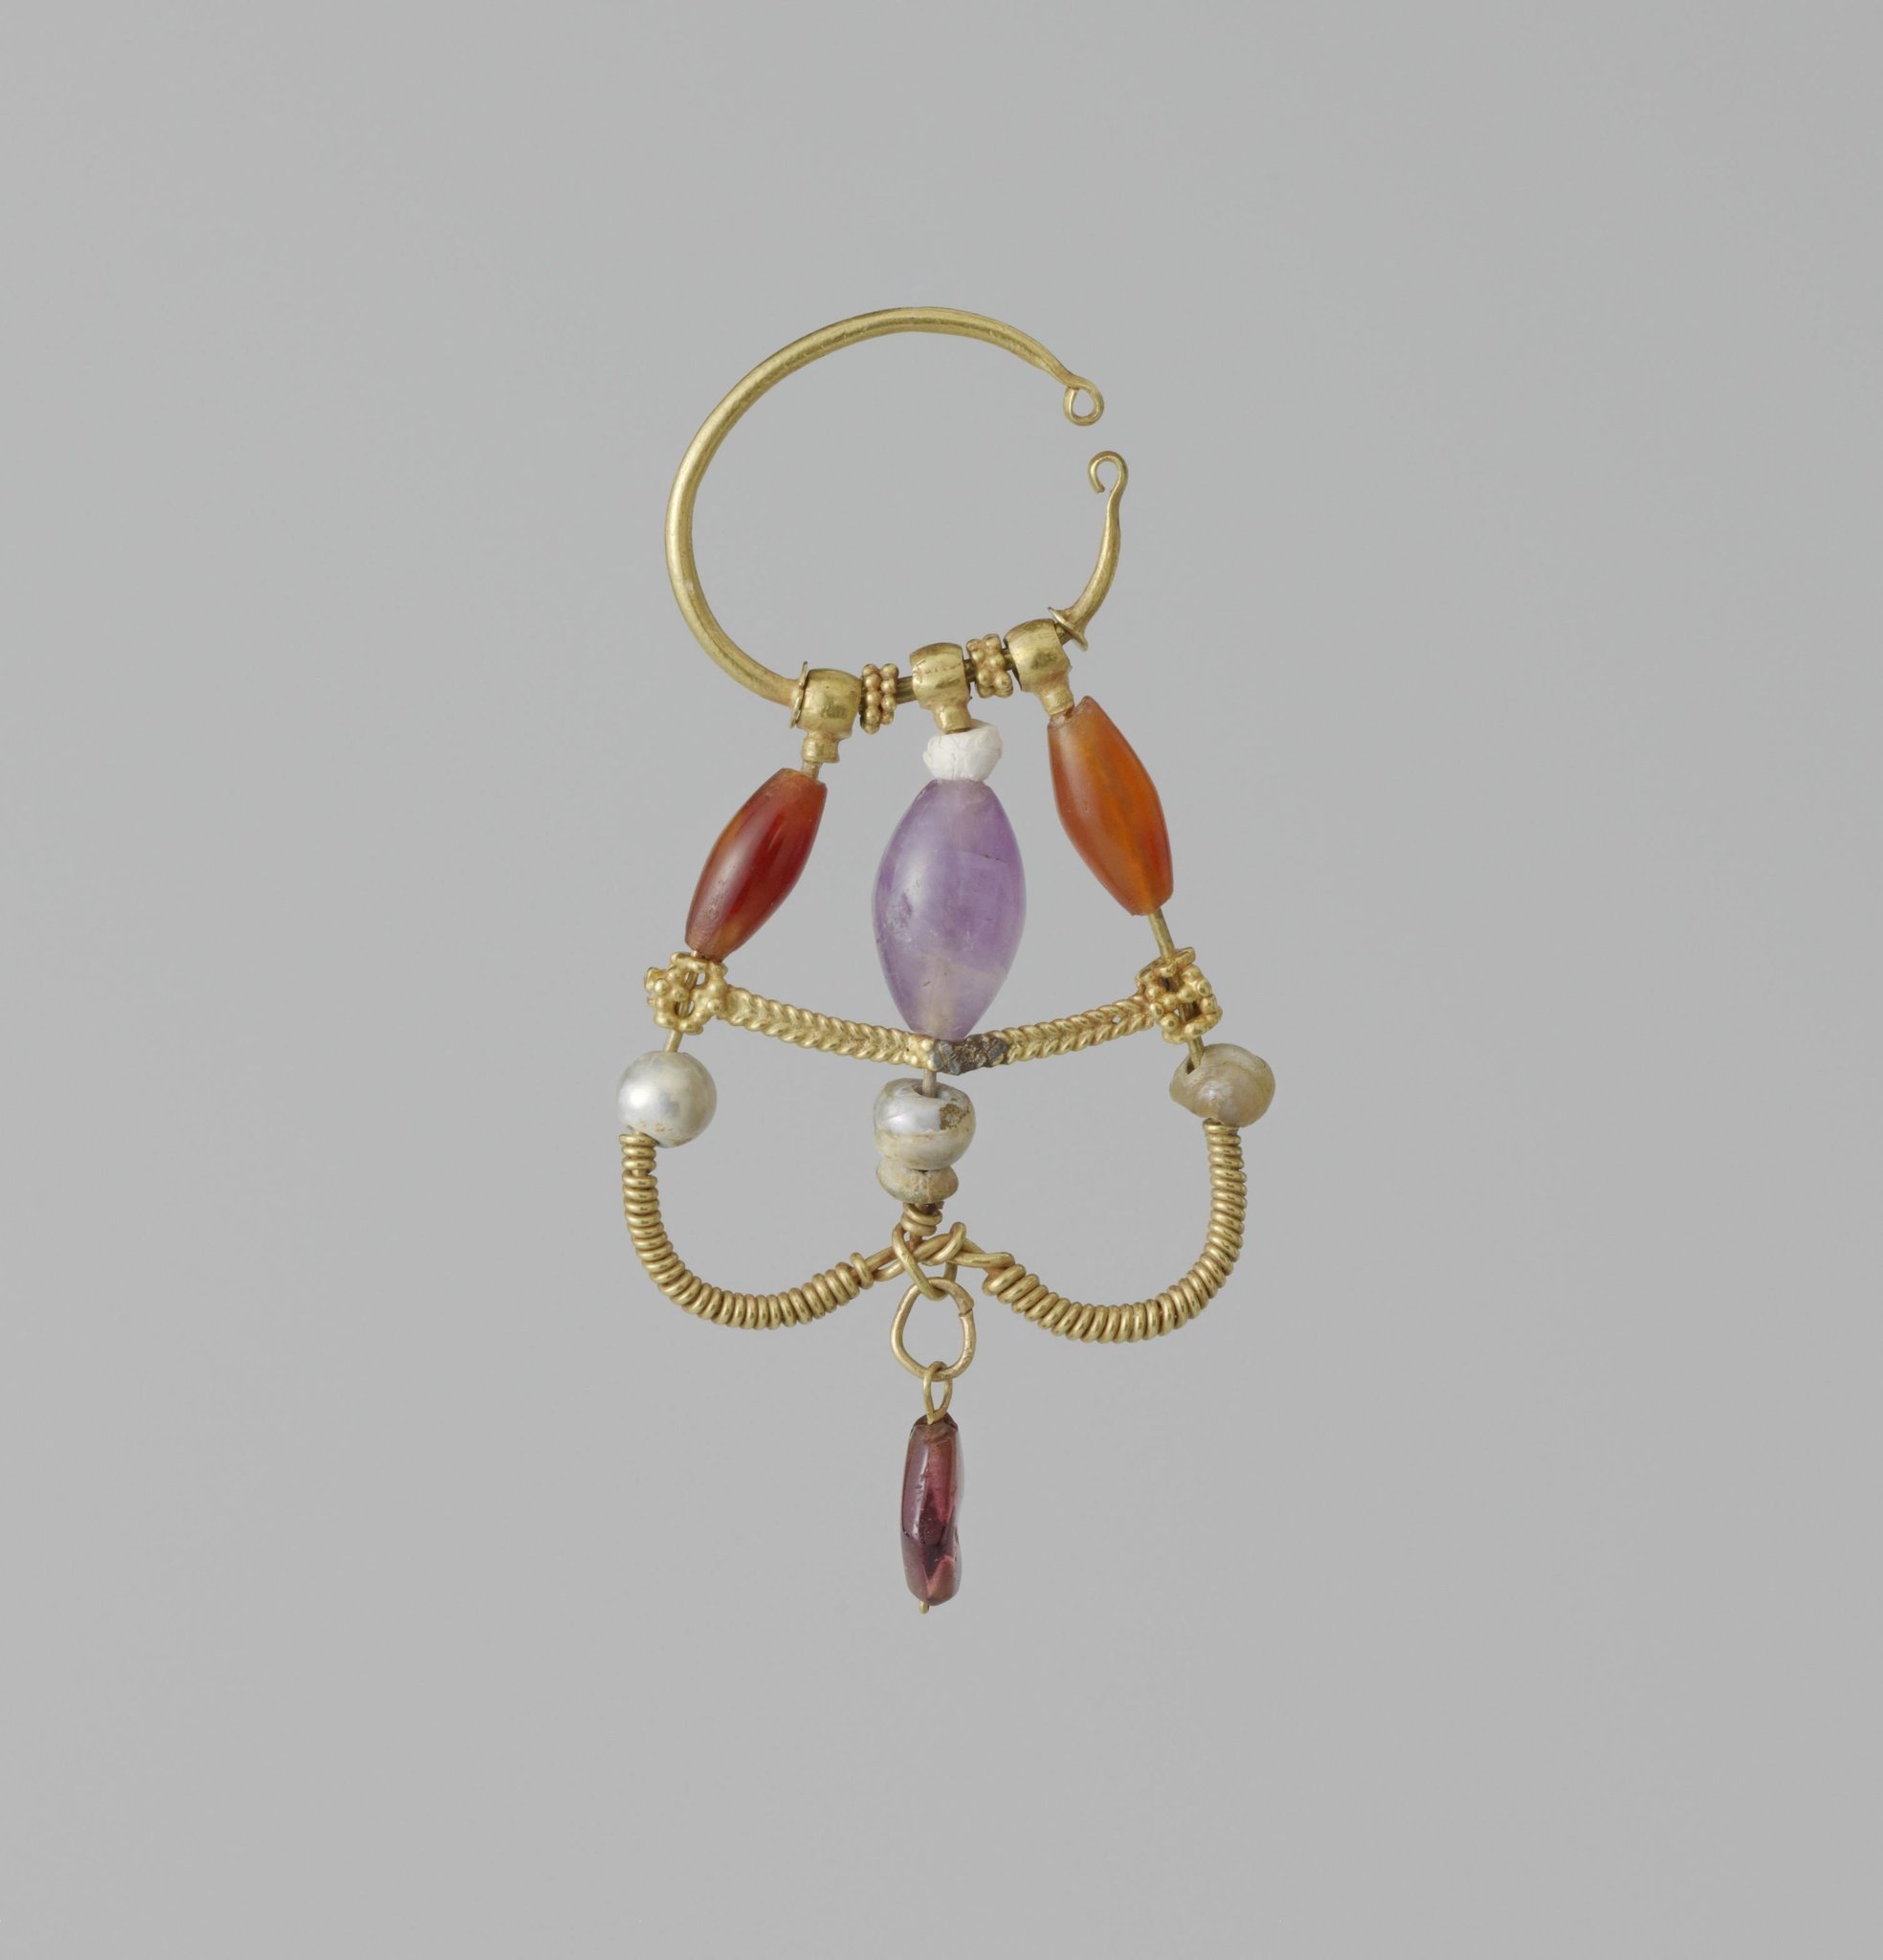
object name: ear ornament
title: Oorhanger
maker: Anonymous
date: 400-500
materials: gemstone, gold, pearl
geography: syria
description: Earring. Gold, amethyst, cornelian, pearl. Syria, 5th century.